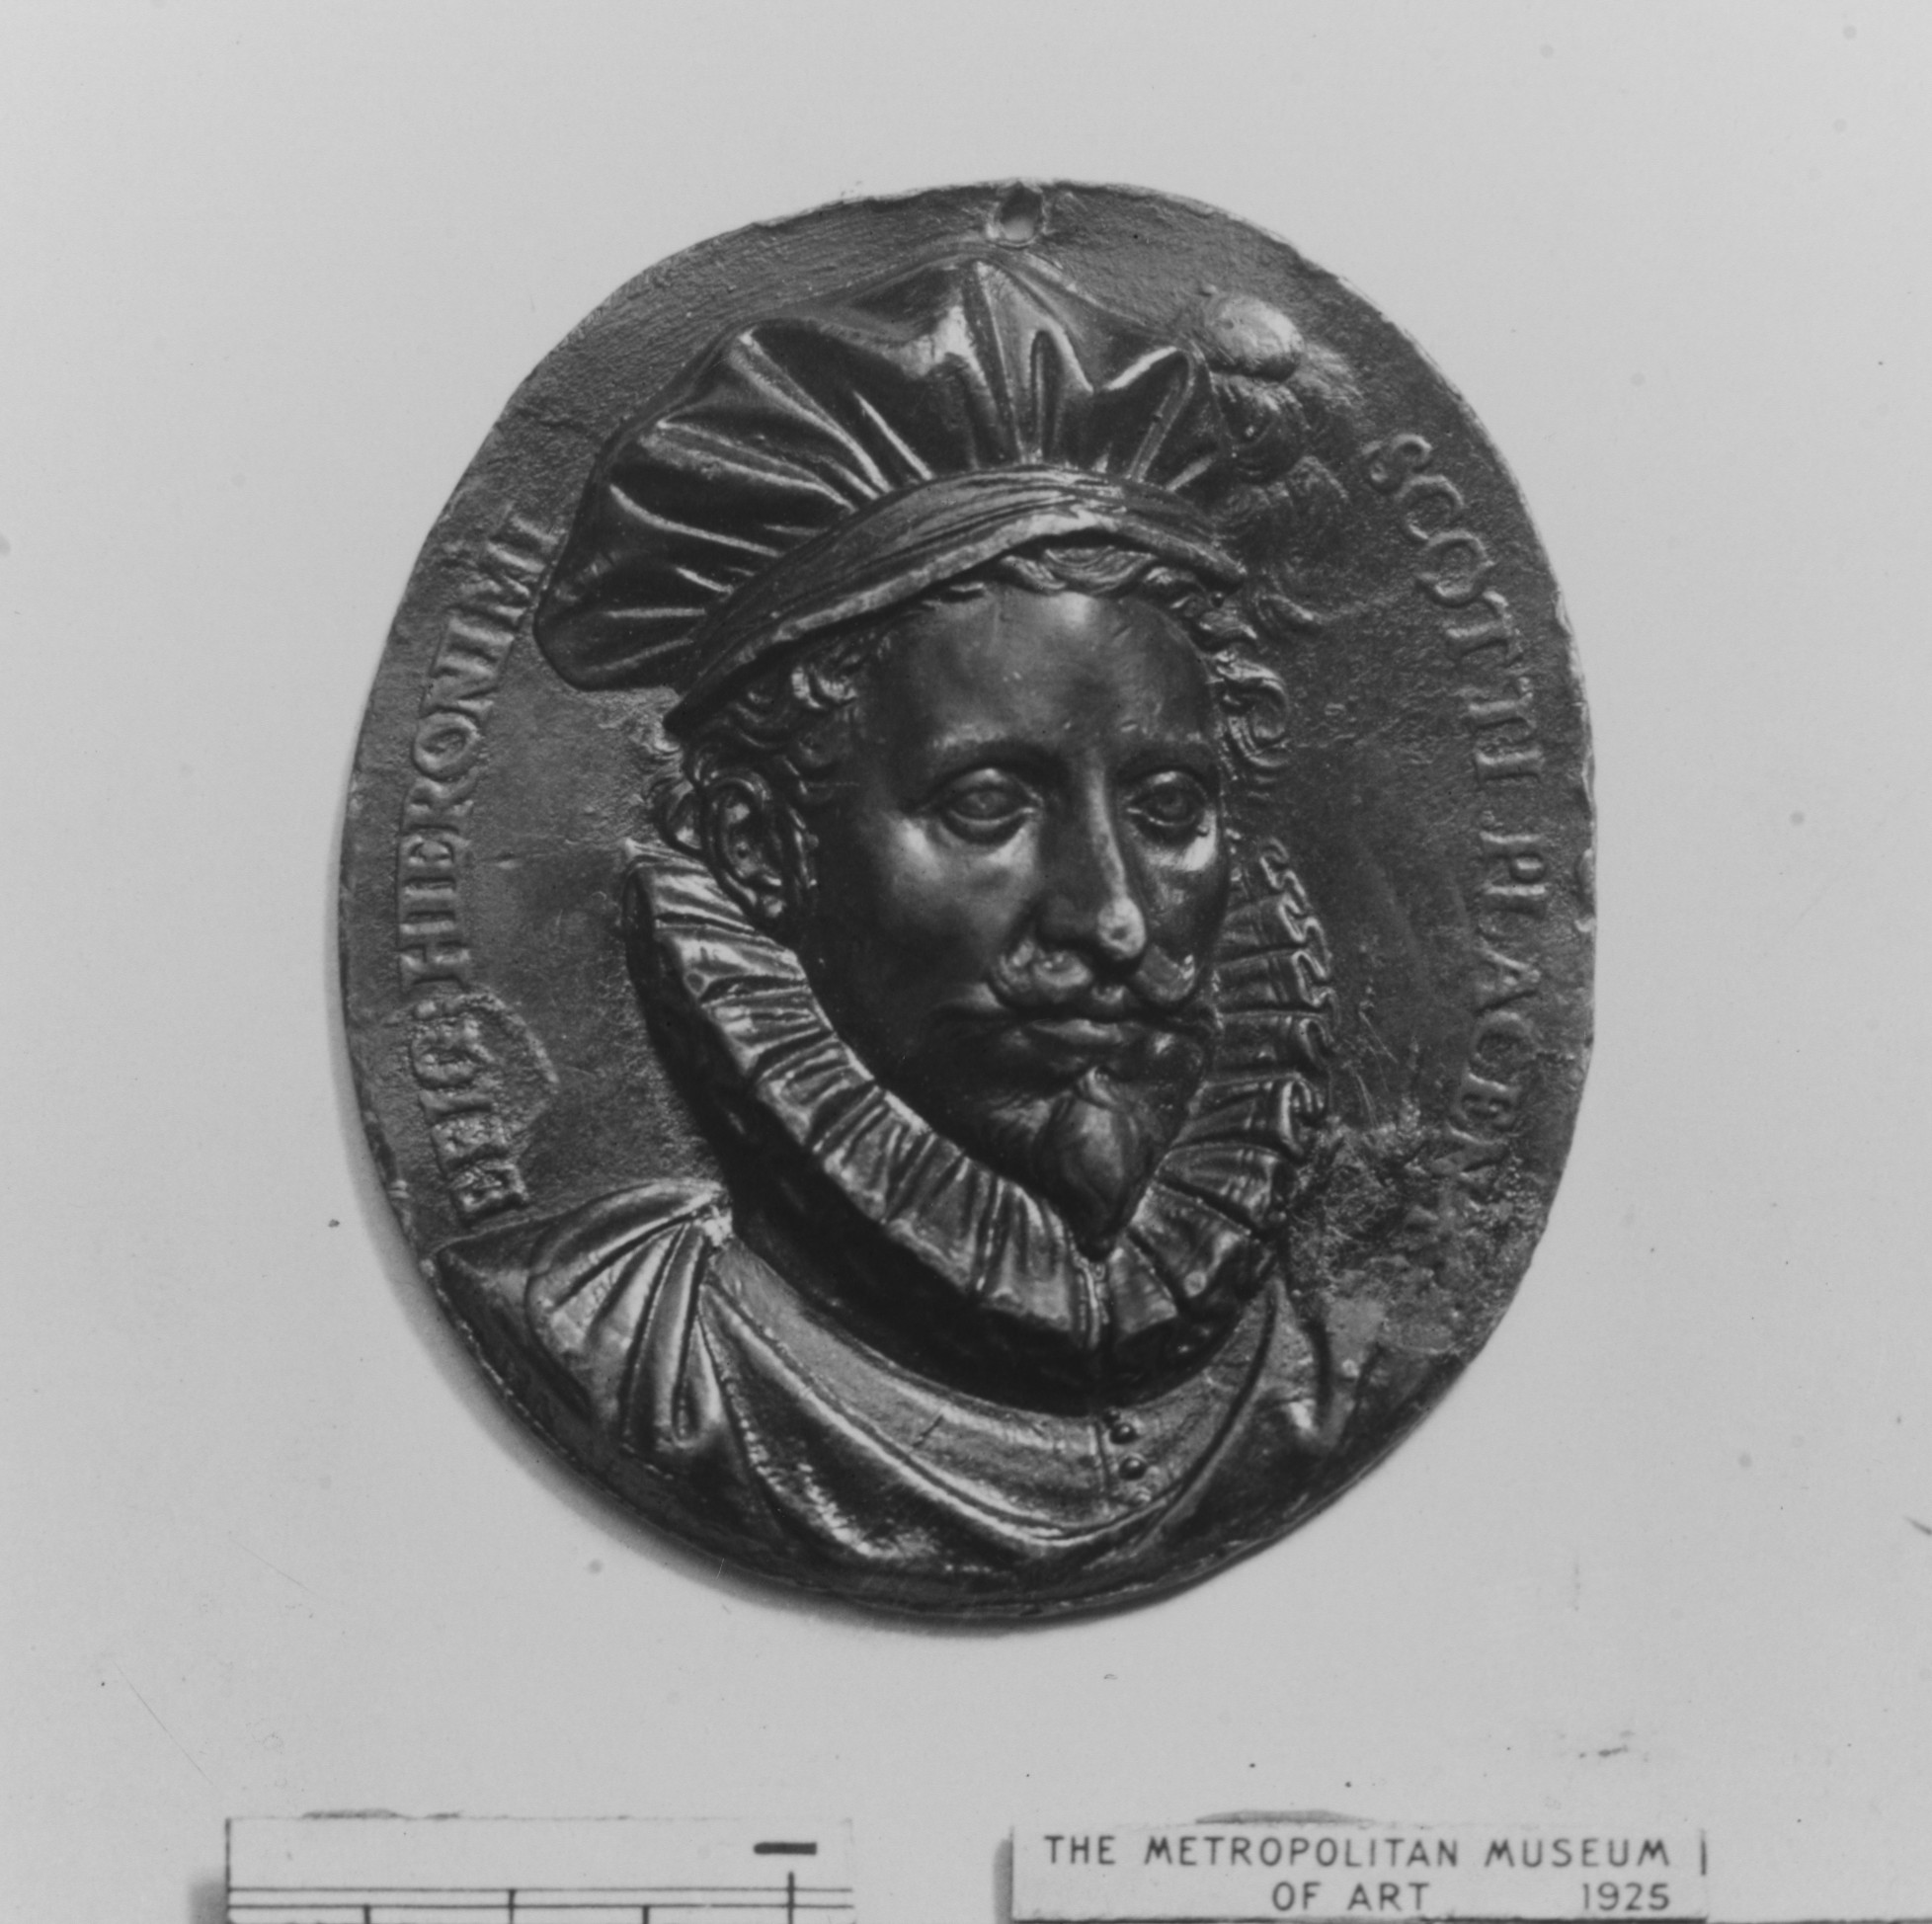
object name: medal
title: Hieronymus Scotti, Magician and Alchemist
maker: antonio abondio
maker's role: artist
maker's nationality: italian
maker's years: 1538-1591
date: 1580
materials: lead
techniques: casting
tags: men,portraits